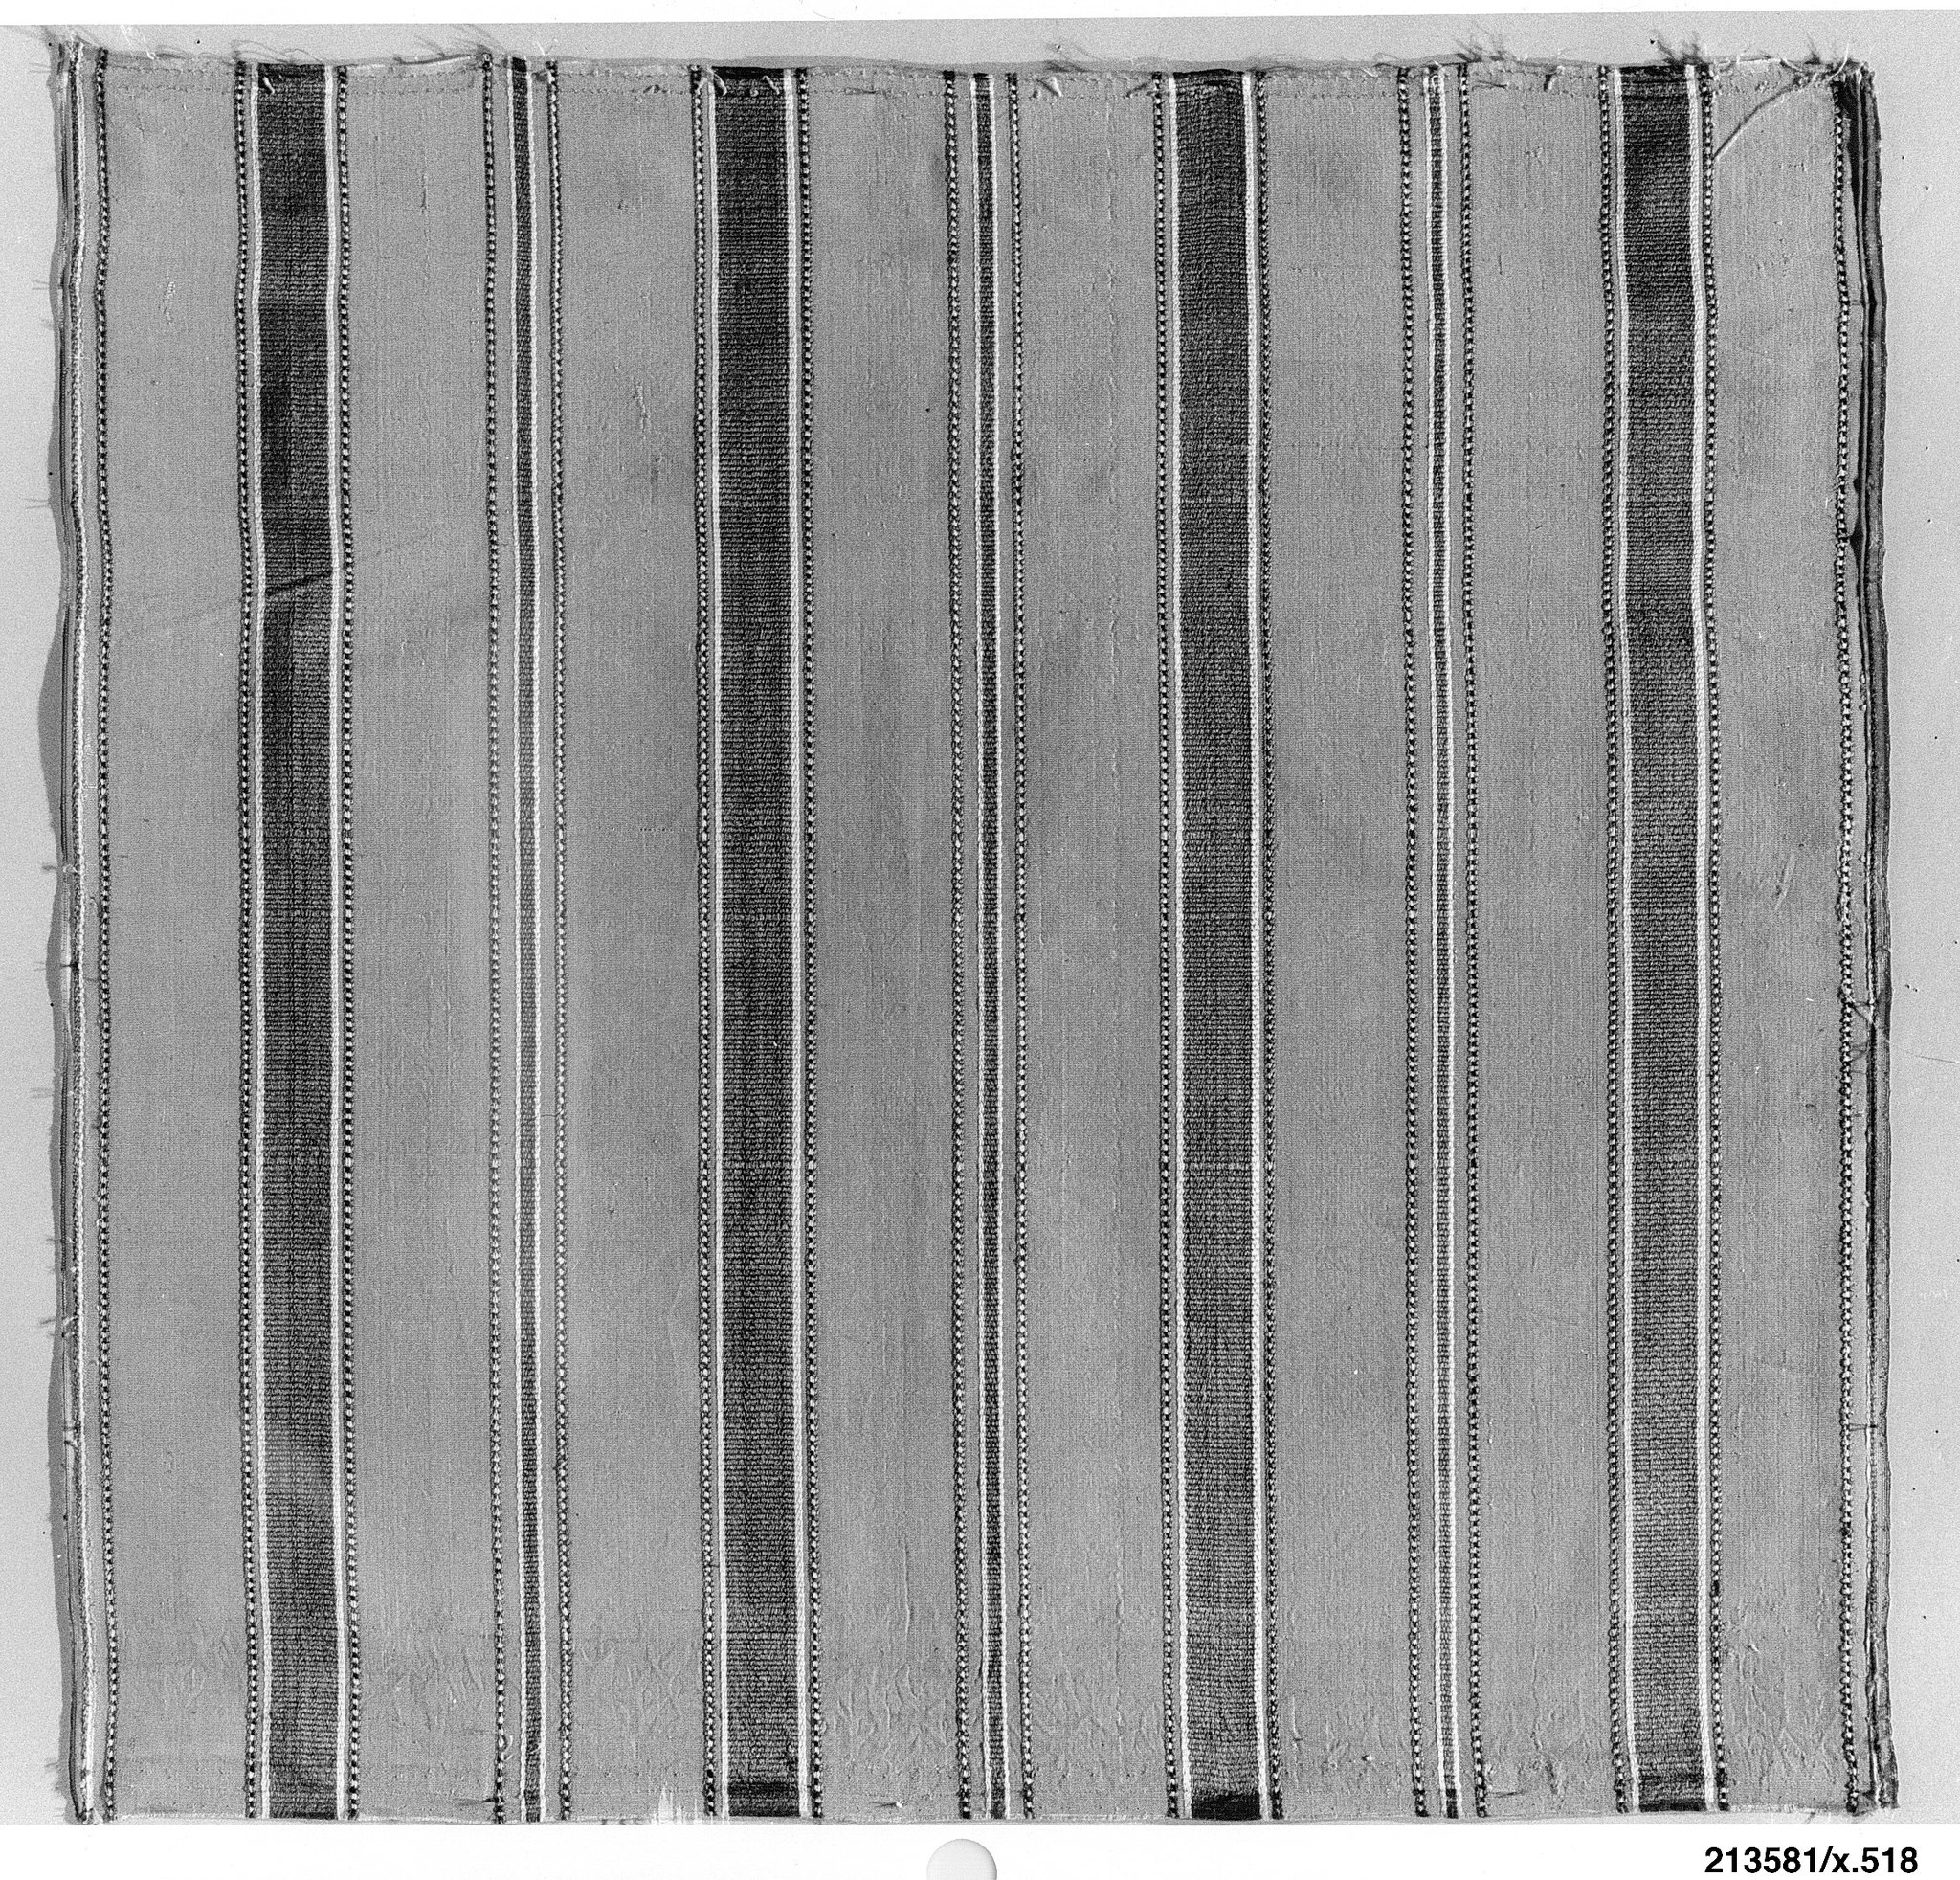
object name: piece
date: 1701-1800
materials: silk